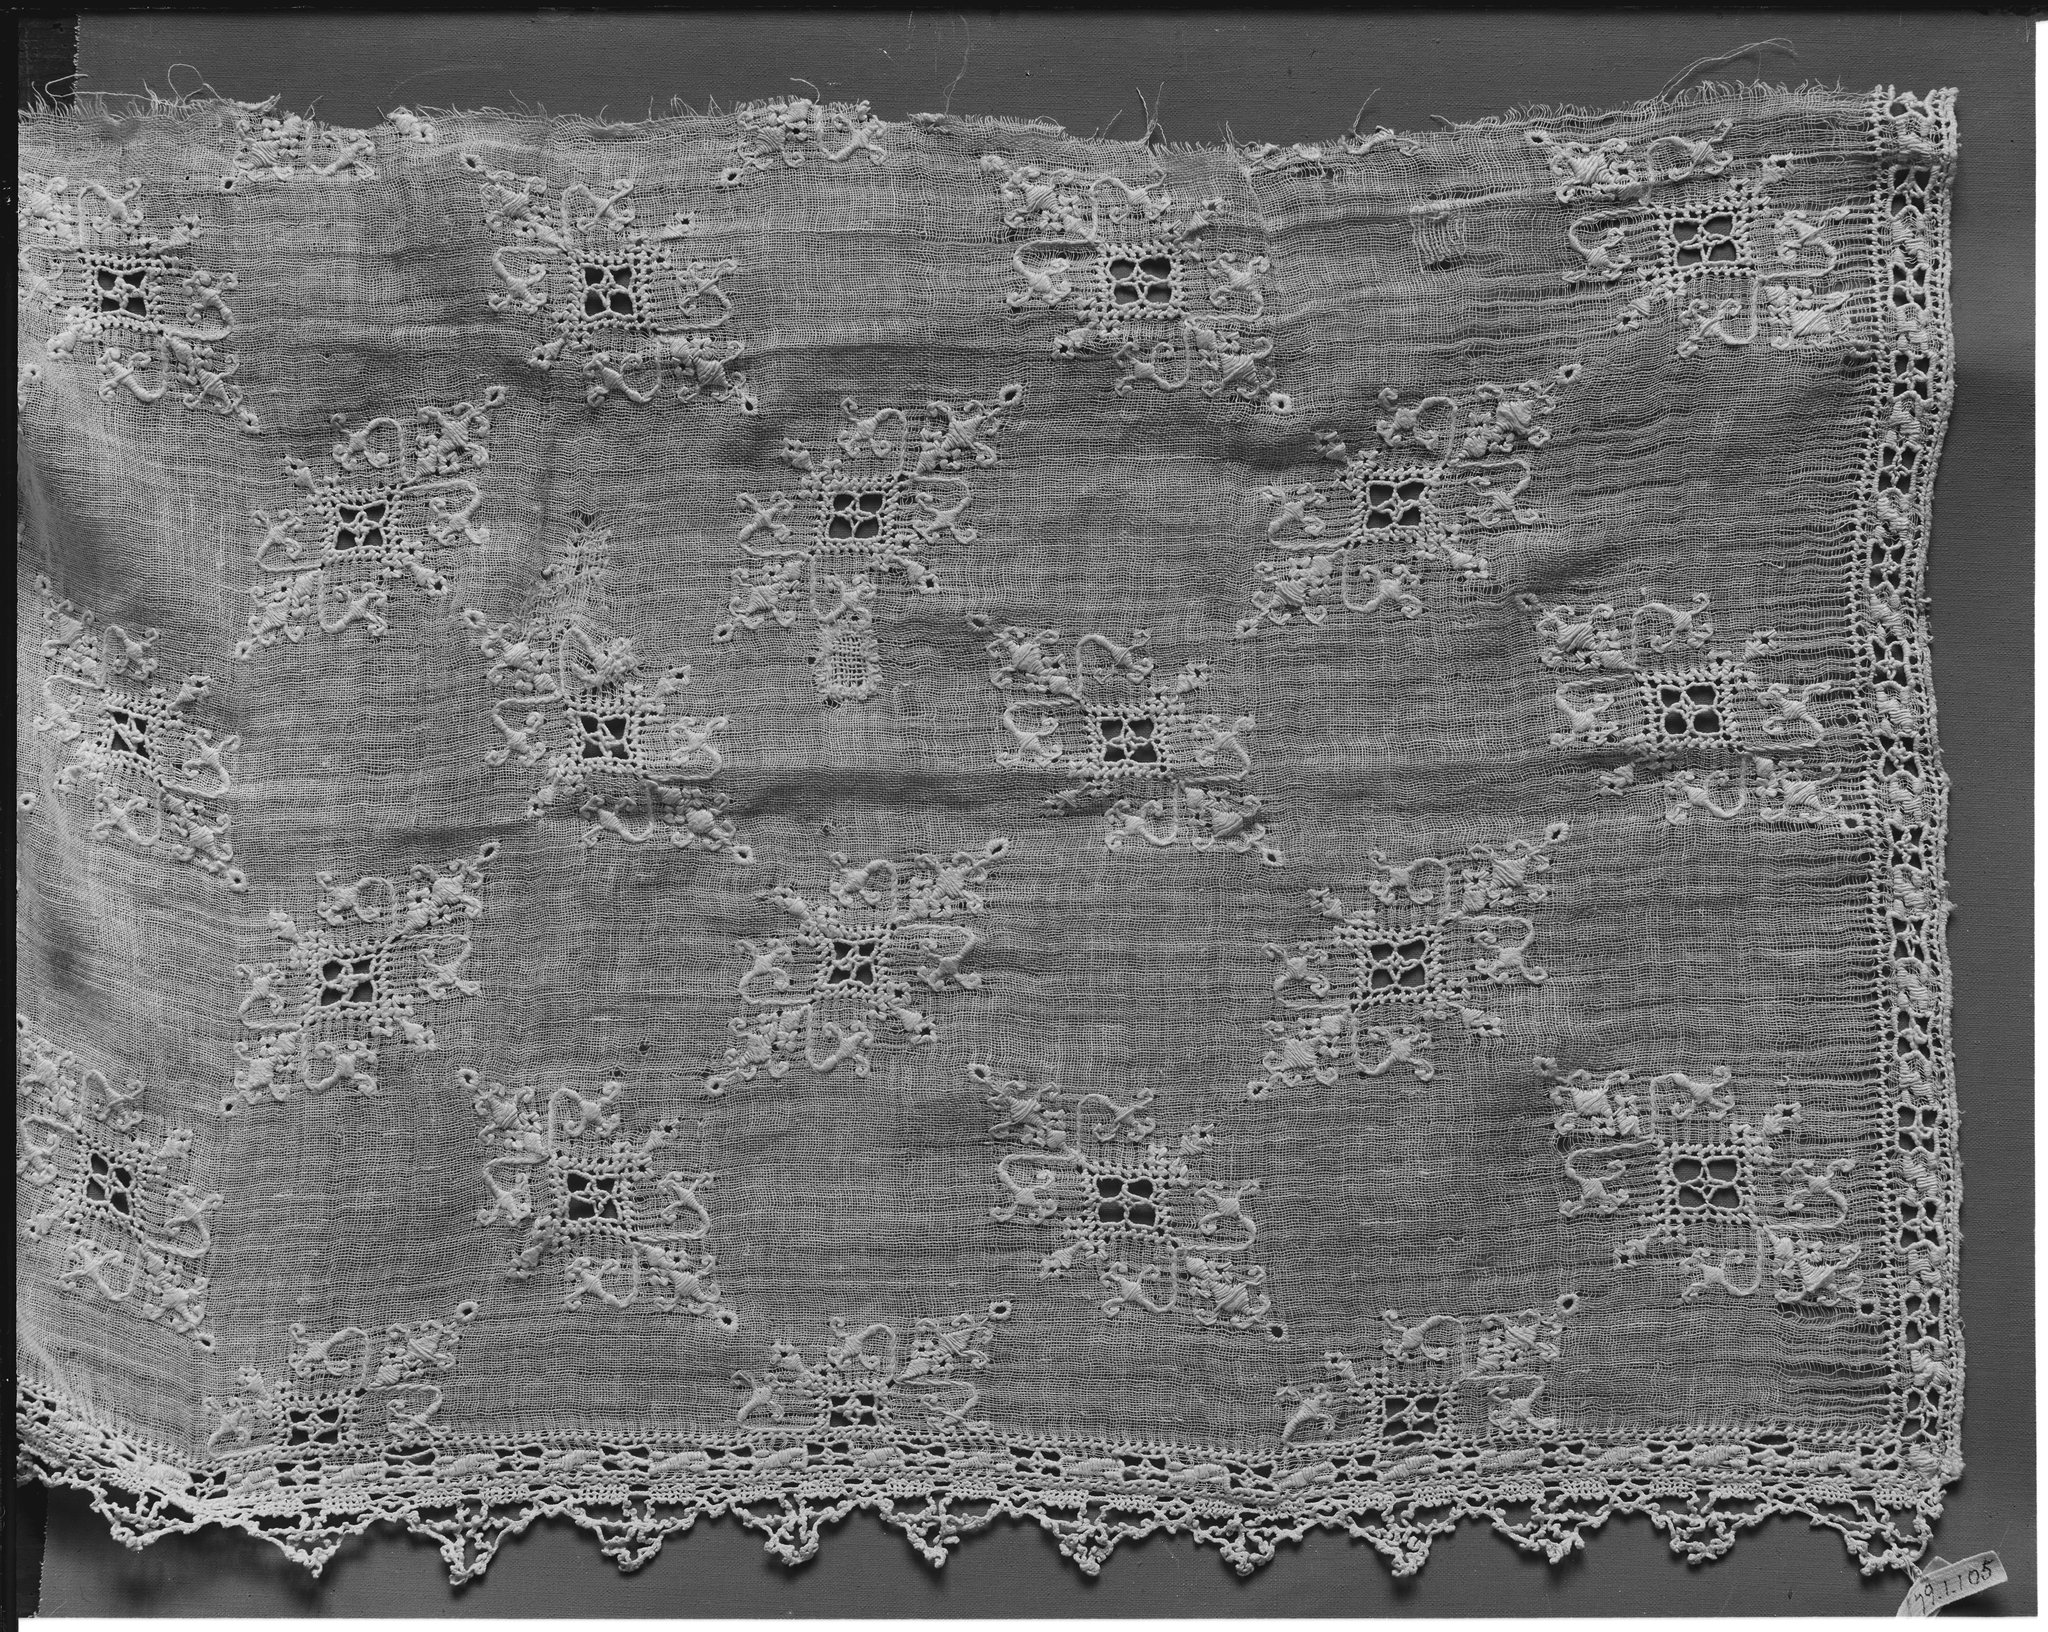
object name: fragment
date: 1600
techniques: embroidery